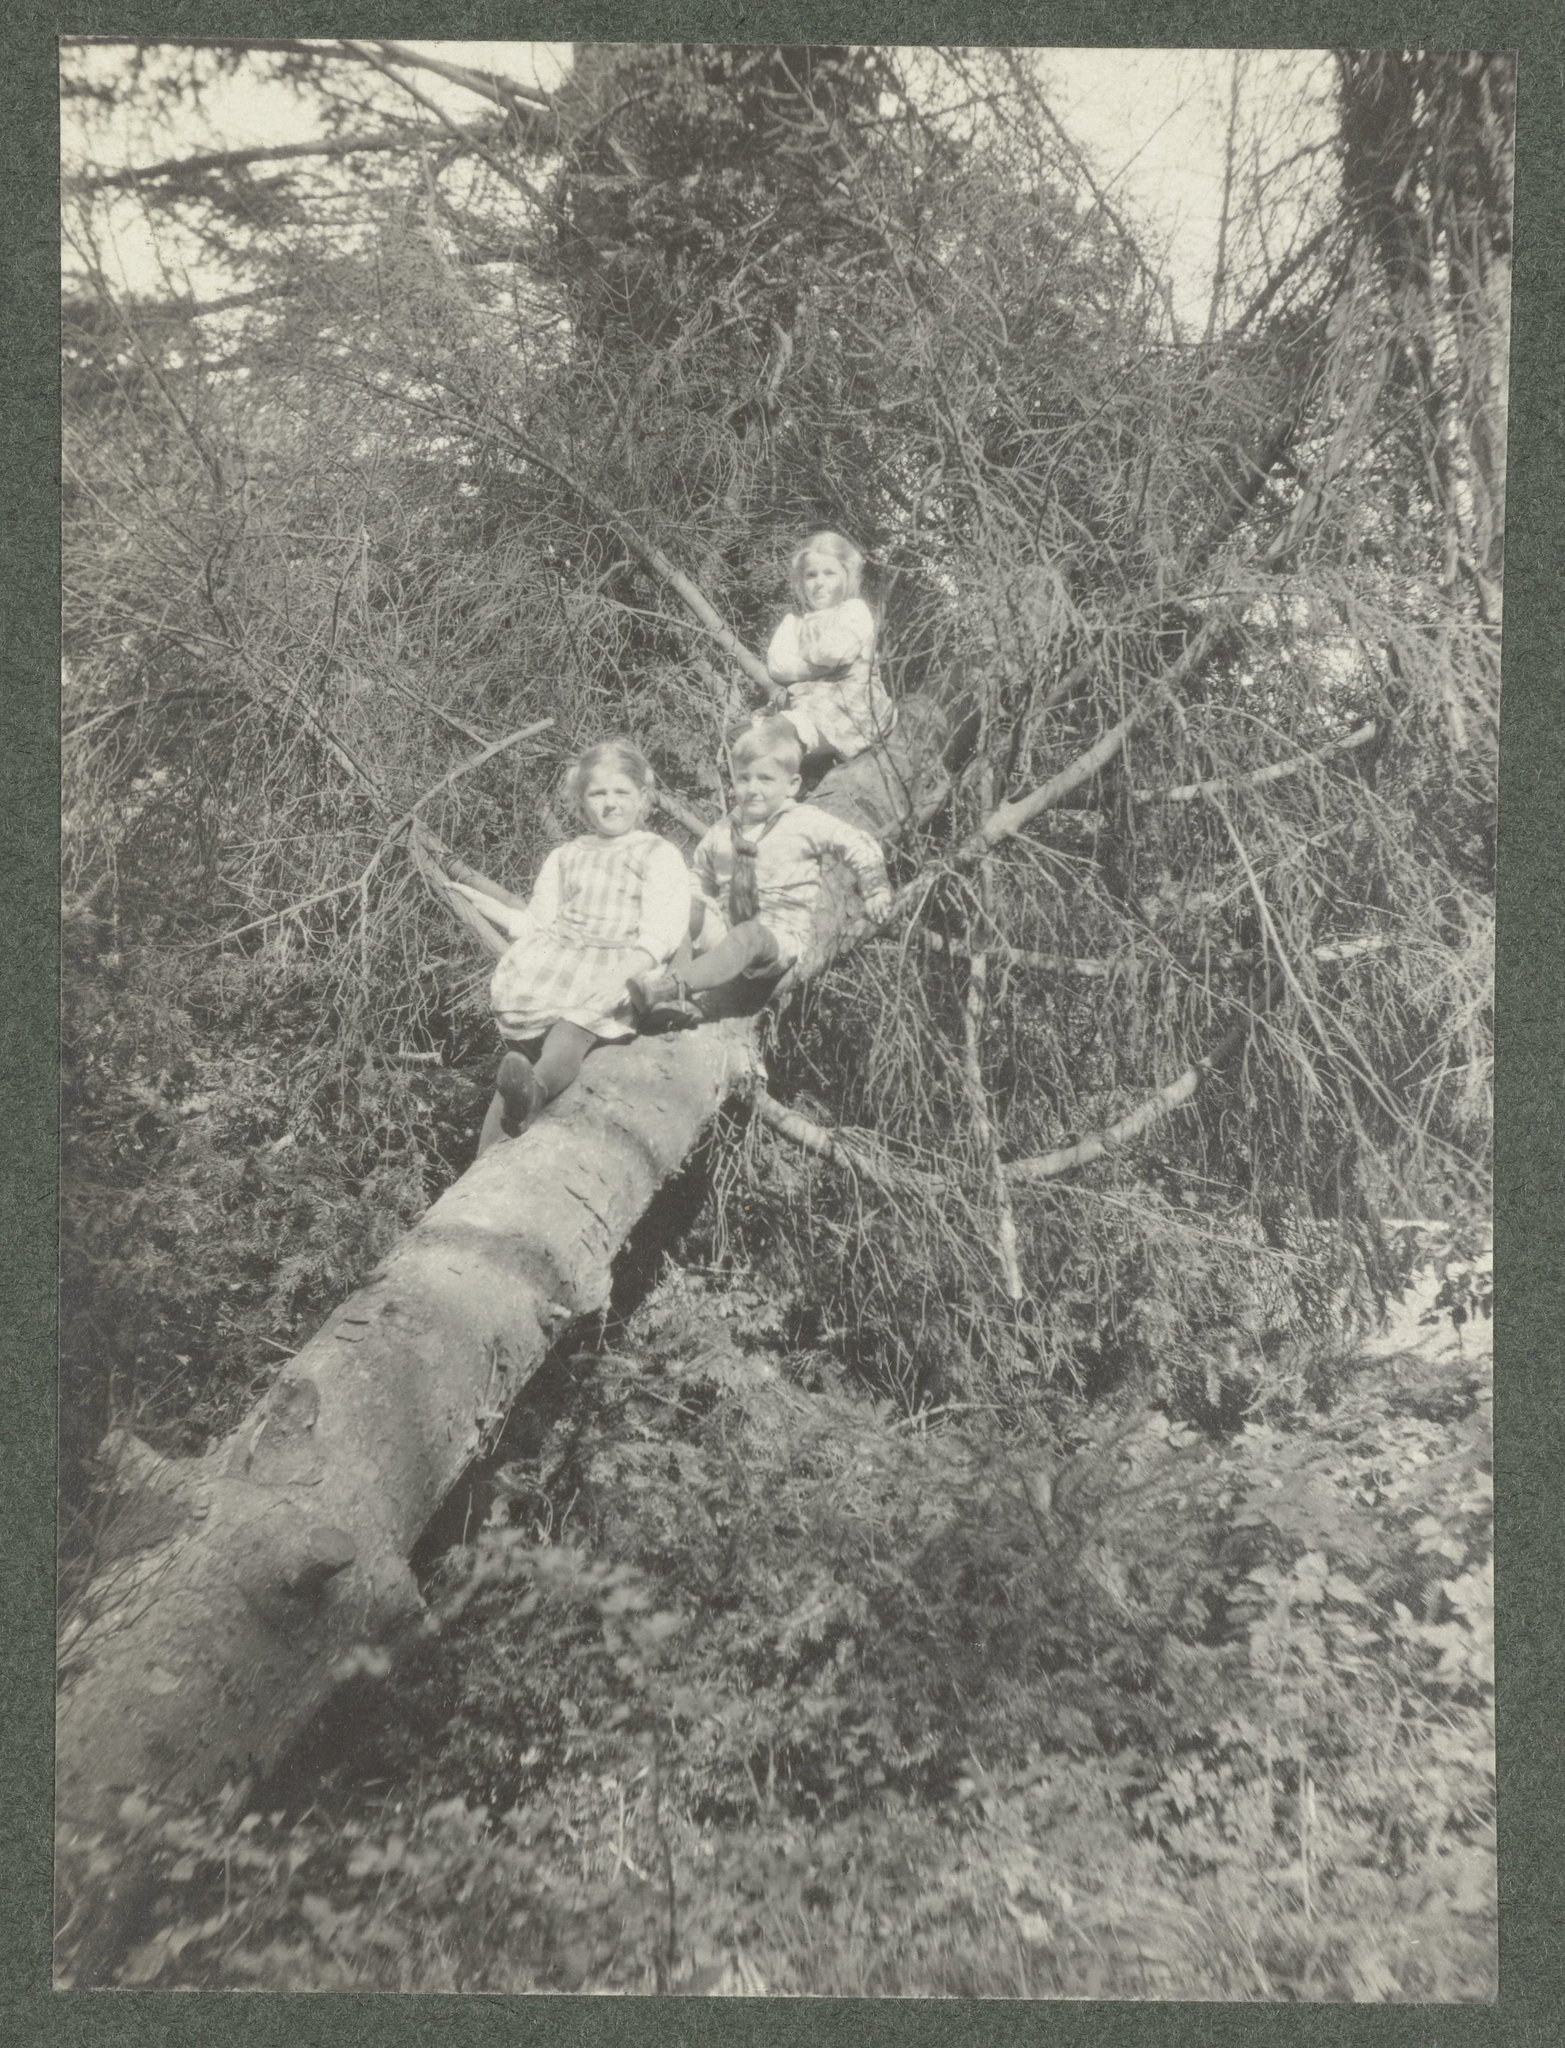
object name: photograph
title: Drie kleine kinderen op een omgevallen boom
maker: geldolph adriaan kessler (dolph)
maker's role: fotograaf, industrieel, voetballer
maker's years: 1884-1945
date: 1913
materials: paper, photographic support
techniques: photography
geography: netherlands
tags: huize de paauw